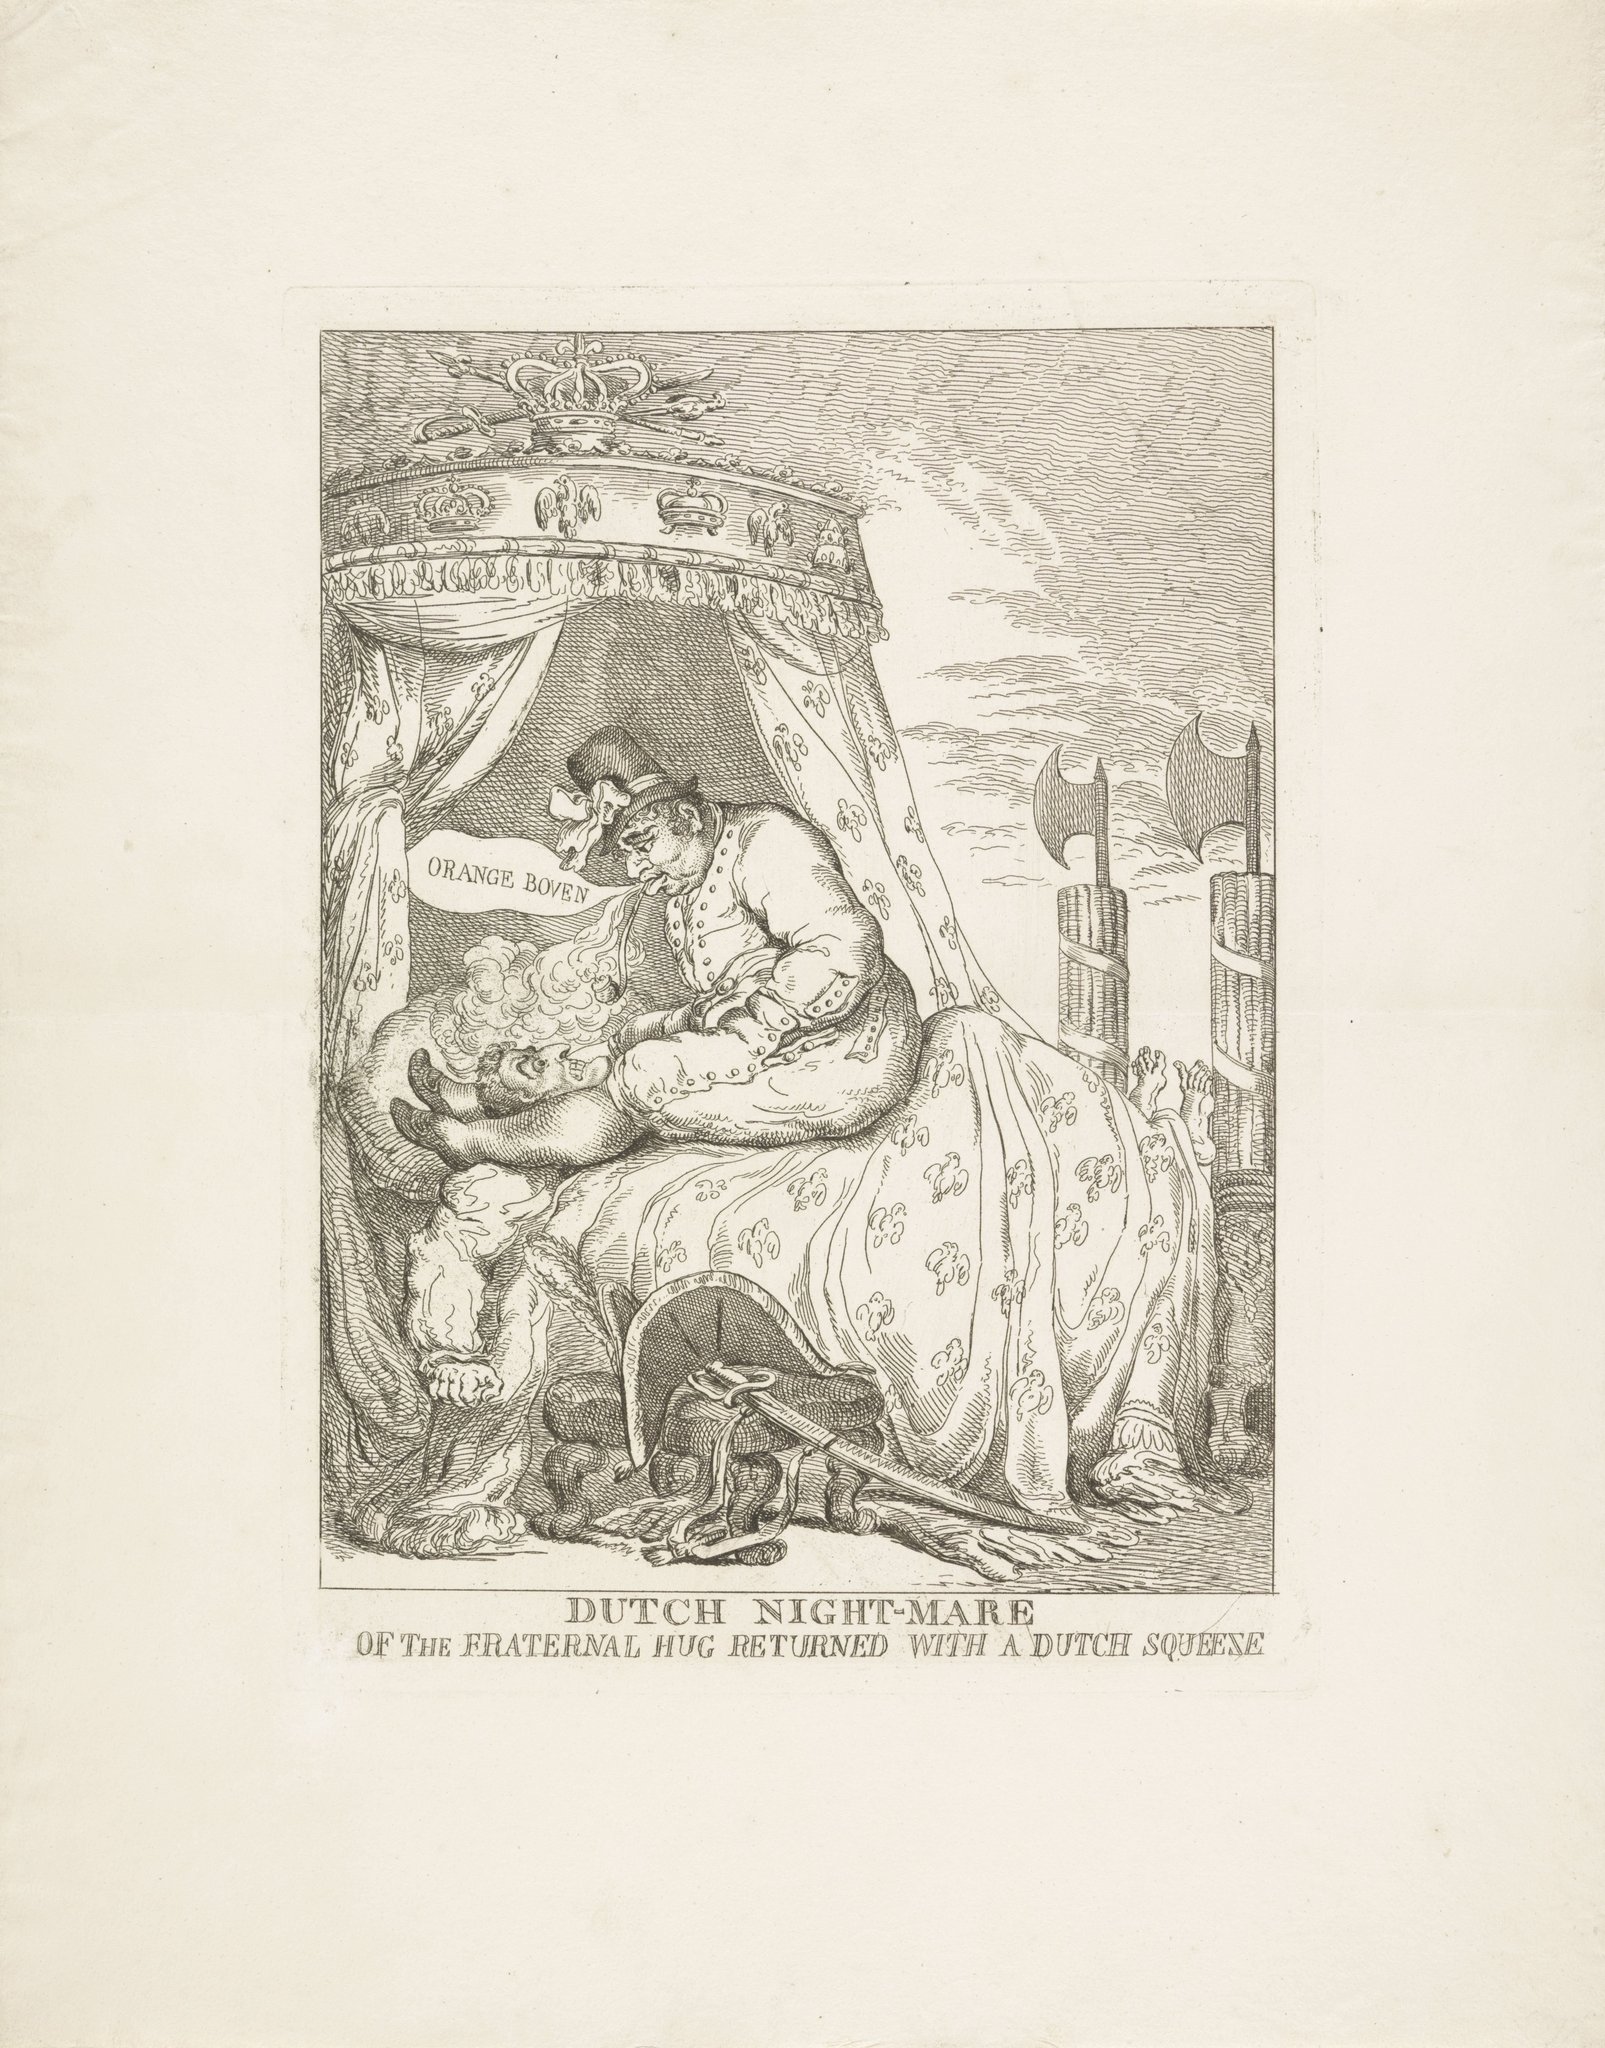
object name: cartoon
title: Dutch night-mare of the fraternal hug returned with a Dutch squeeze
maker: Anonymous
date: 1813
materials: paper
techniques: etching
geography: england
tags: napoleon i (emperor of the french), sitting figure, nightmare, pipe ~ tobacco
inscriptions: collector's mark: Lugt 2228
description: Spotprent op de val van Napoleon, 1813. Napoleon liggend in zijn keizerlijke bed met een dikke Hollander gezeten op zijn borst. De Hollander zegt 'Orange Boven' en draagt een grote oranje lint en kokarde op zijn hoed. Hij klemt het hoofd van Napoleon tussen zijn benen in een 'Dutch squeeze' en blaast tabaksrook van zijn pijp in het gezicht van de keizer. Met twee grote pijlenbundels aan de voet van het bed.